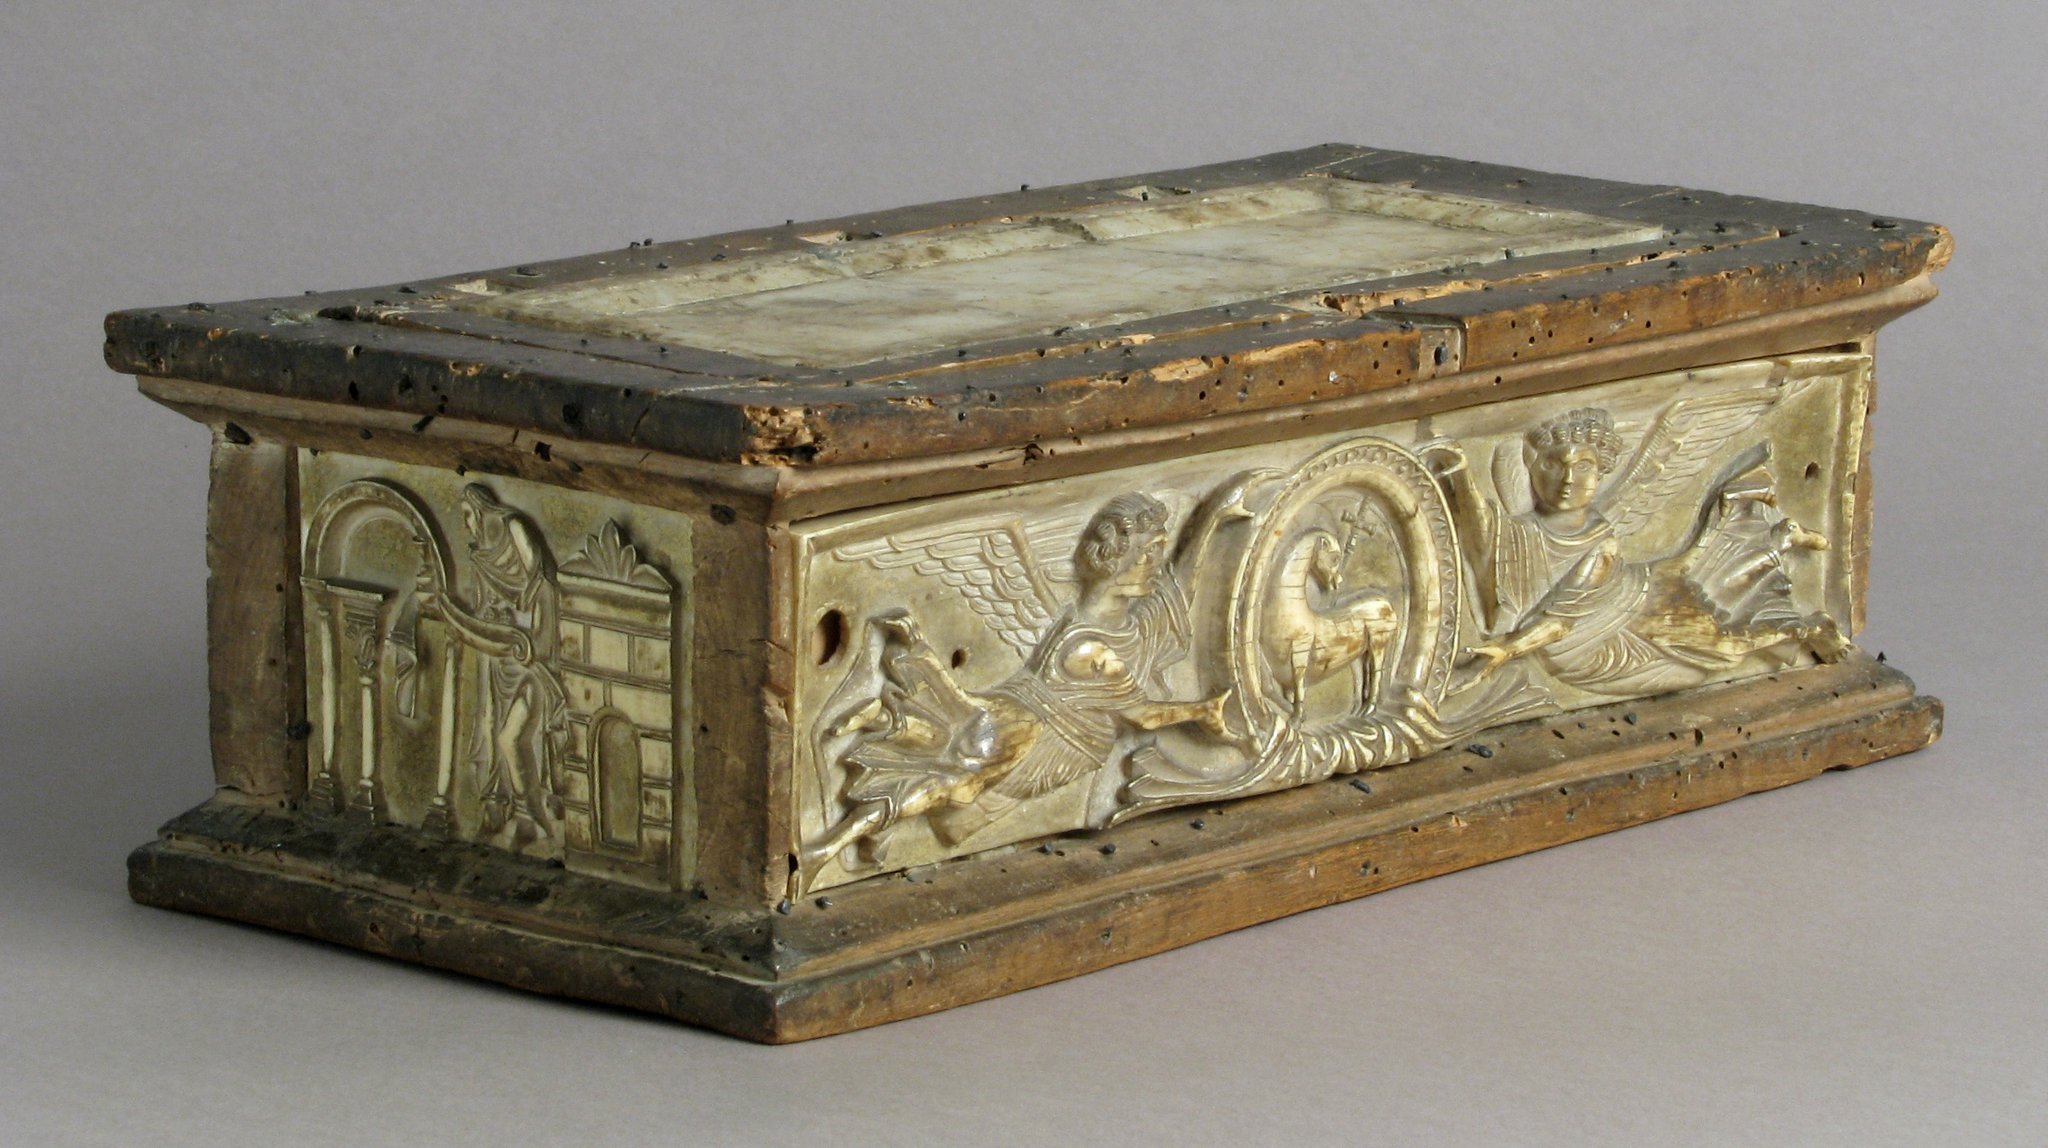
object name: portable altar and side panel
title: Portable Altar and Two Side Panels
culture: european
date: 801-1200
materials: gold, ivory, shell, stone, wood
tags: animals,angels